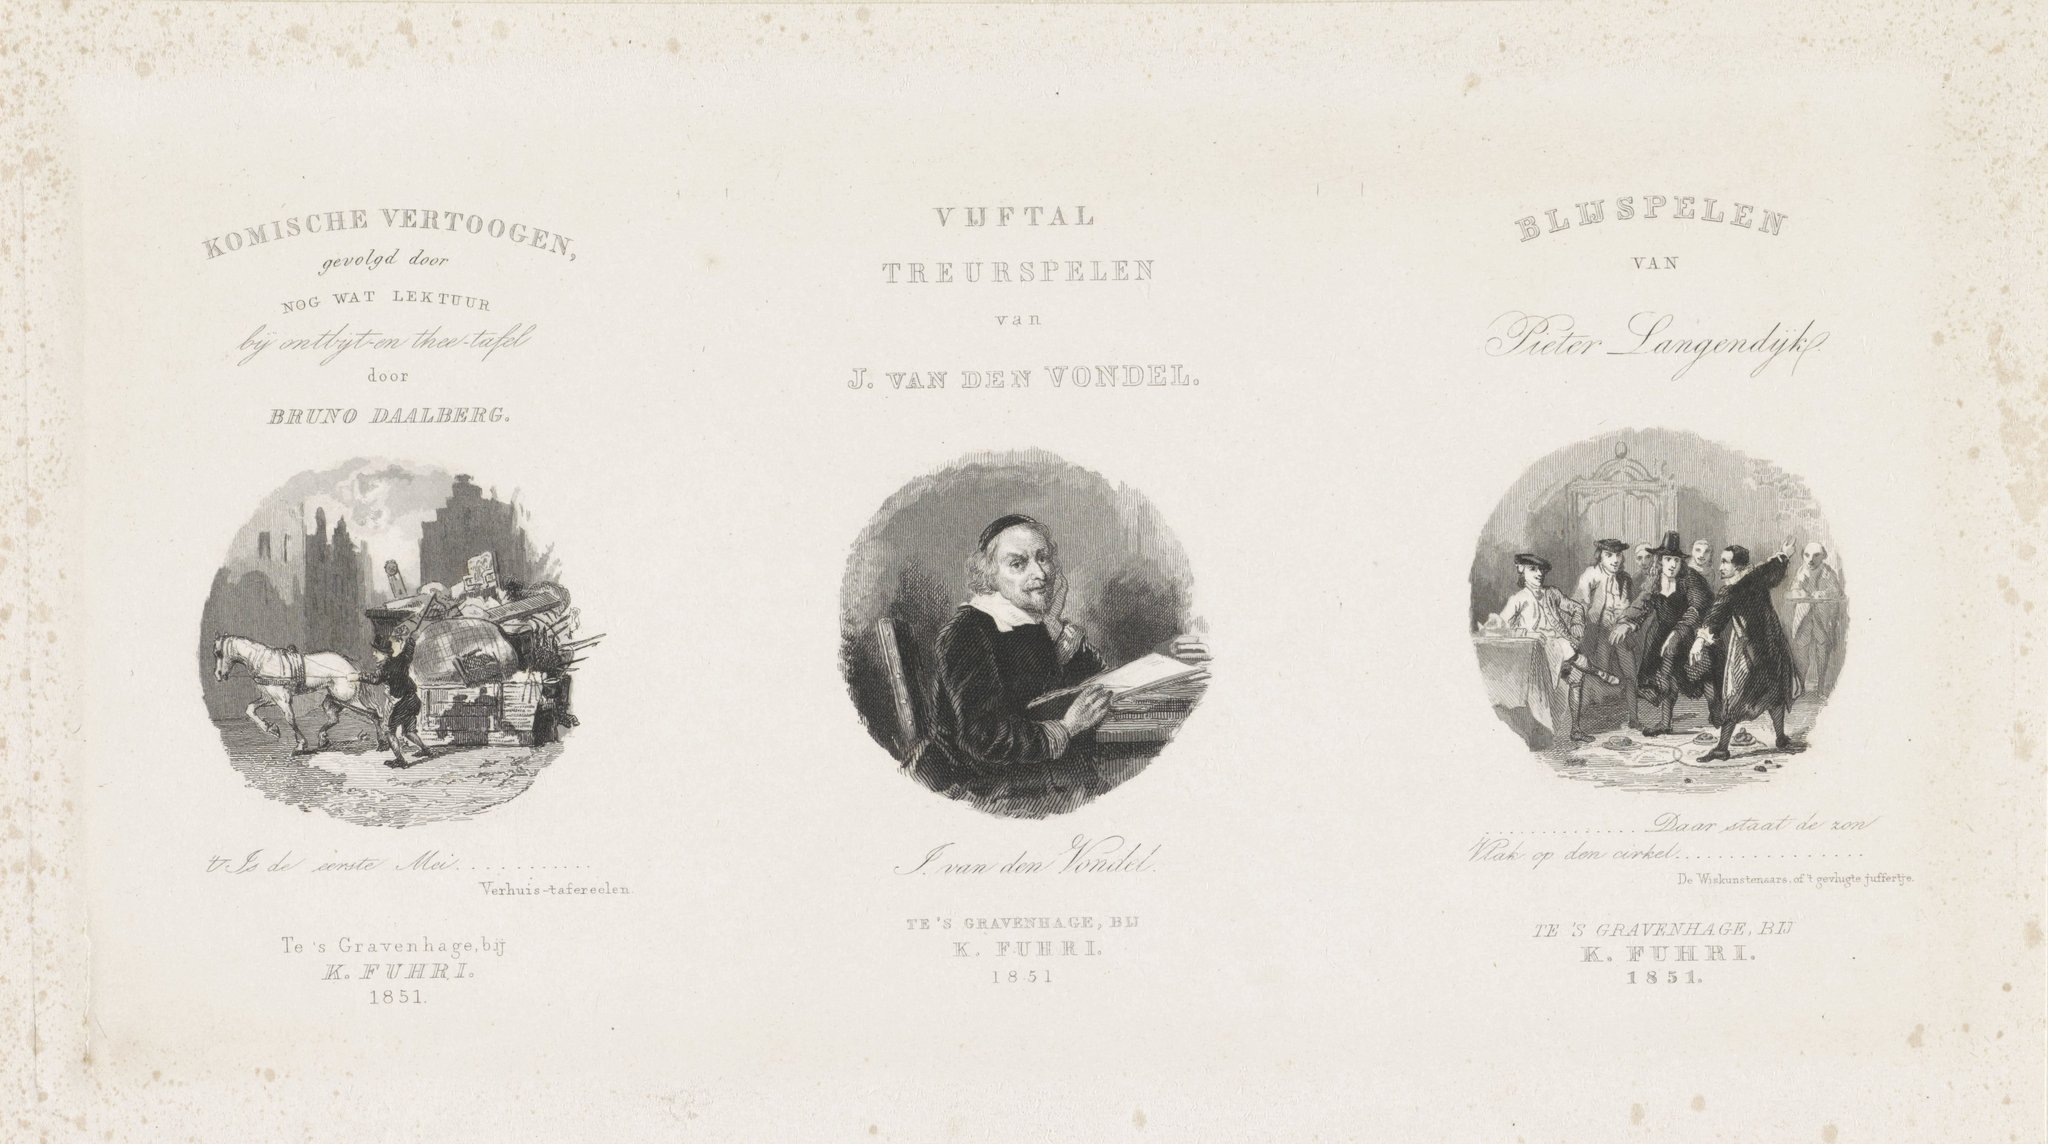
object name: titelblad, titelpagina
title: Titelpagina's voor drie verschillende boeken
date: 1851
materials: paper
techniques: engraving, etching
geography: the hague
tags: cologne, amsterdam, joost van den vondel, moving (house), historical persons, title-page, mathematics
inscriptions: collector's mark: Lugt 2228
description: Links titelpagina voor: Daalberg, Bruno. Komische vertoogen. Gevolgd door nog wat lektuur bij ontbijt- en thee-tafel, 1851. Op de pagina is een scène uit het verhaal Verhuis-tafeerelen afgebeeld, waarin een man een paard aanspoort om een grote stapel spullen voort te trekken. In het midden een titelpagina met een portret van Joost van den Vondel voor: Vondel, J. van den. Vijftal treurspelen, 1851. Rechts een titelpagina voor: Langendijk, Pieter. Blijspelen, 1851. Op de pagina is een scène uit het blijspel De Wiskunstenaars, of 't gevlugte juffertje afgebeeld, waarin een wiskundige uitleg geeft aan een groep heren.